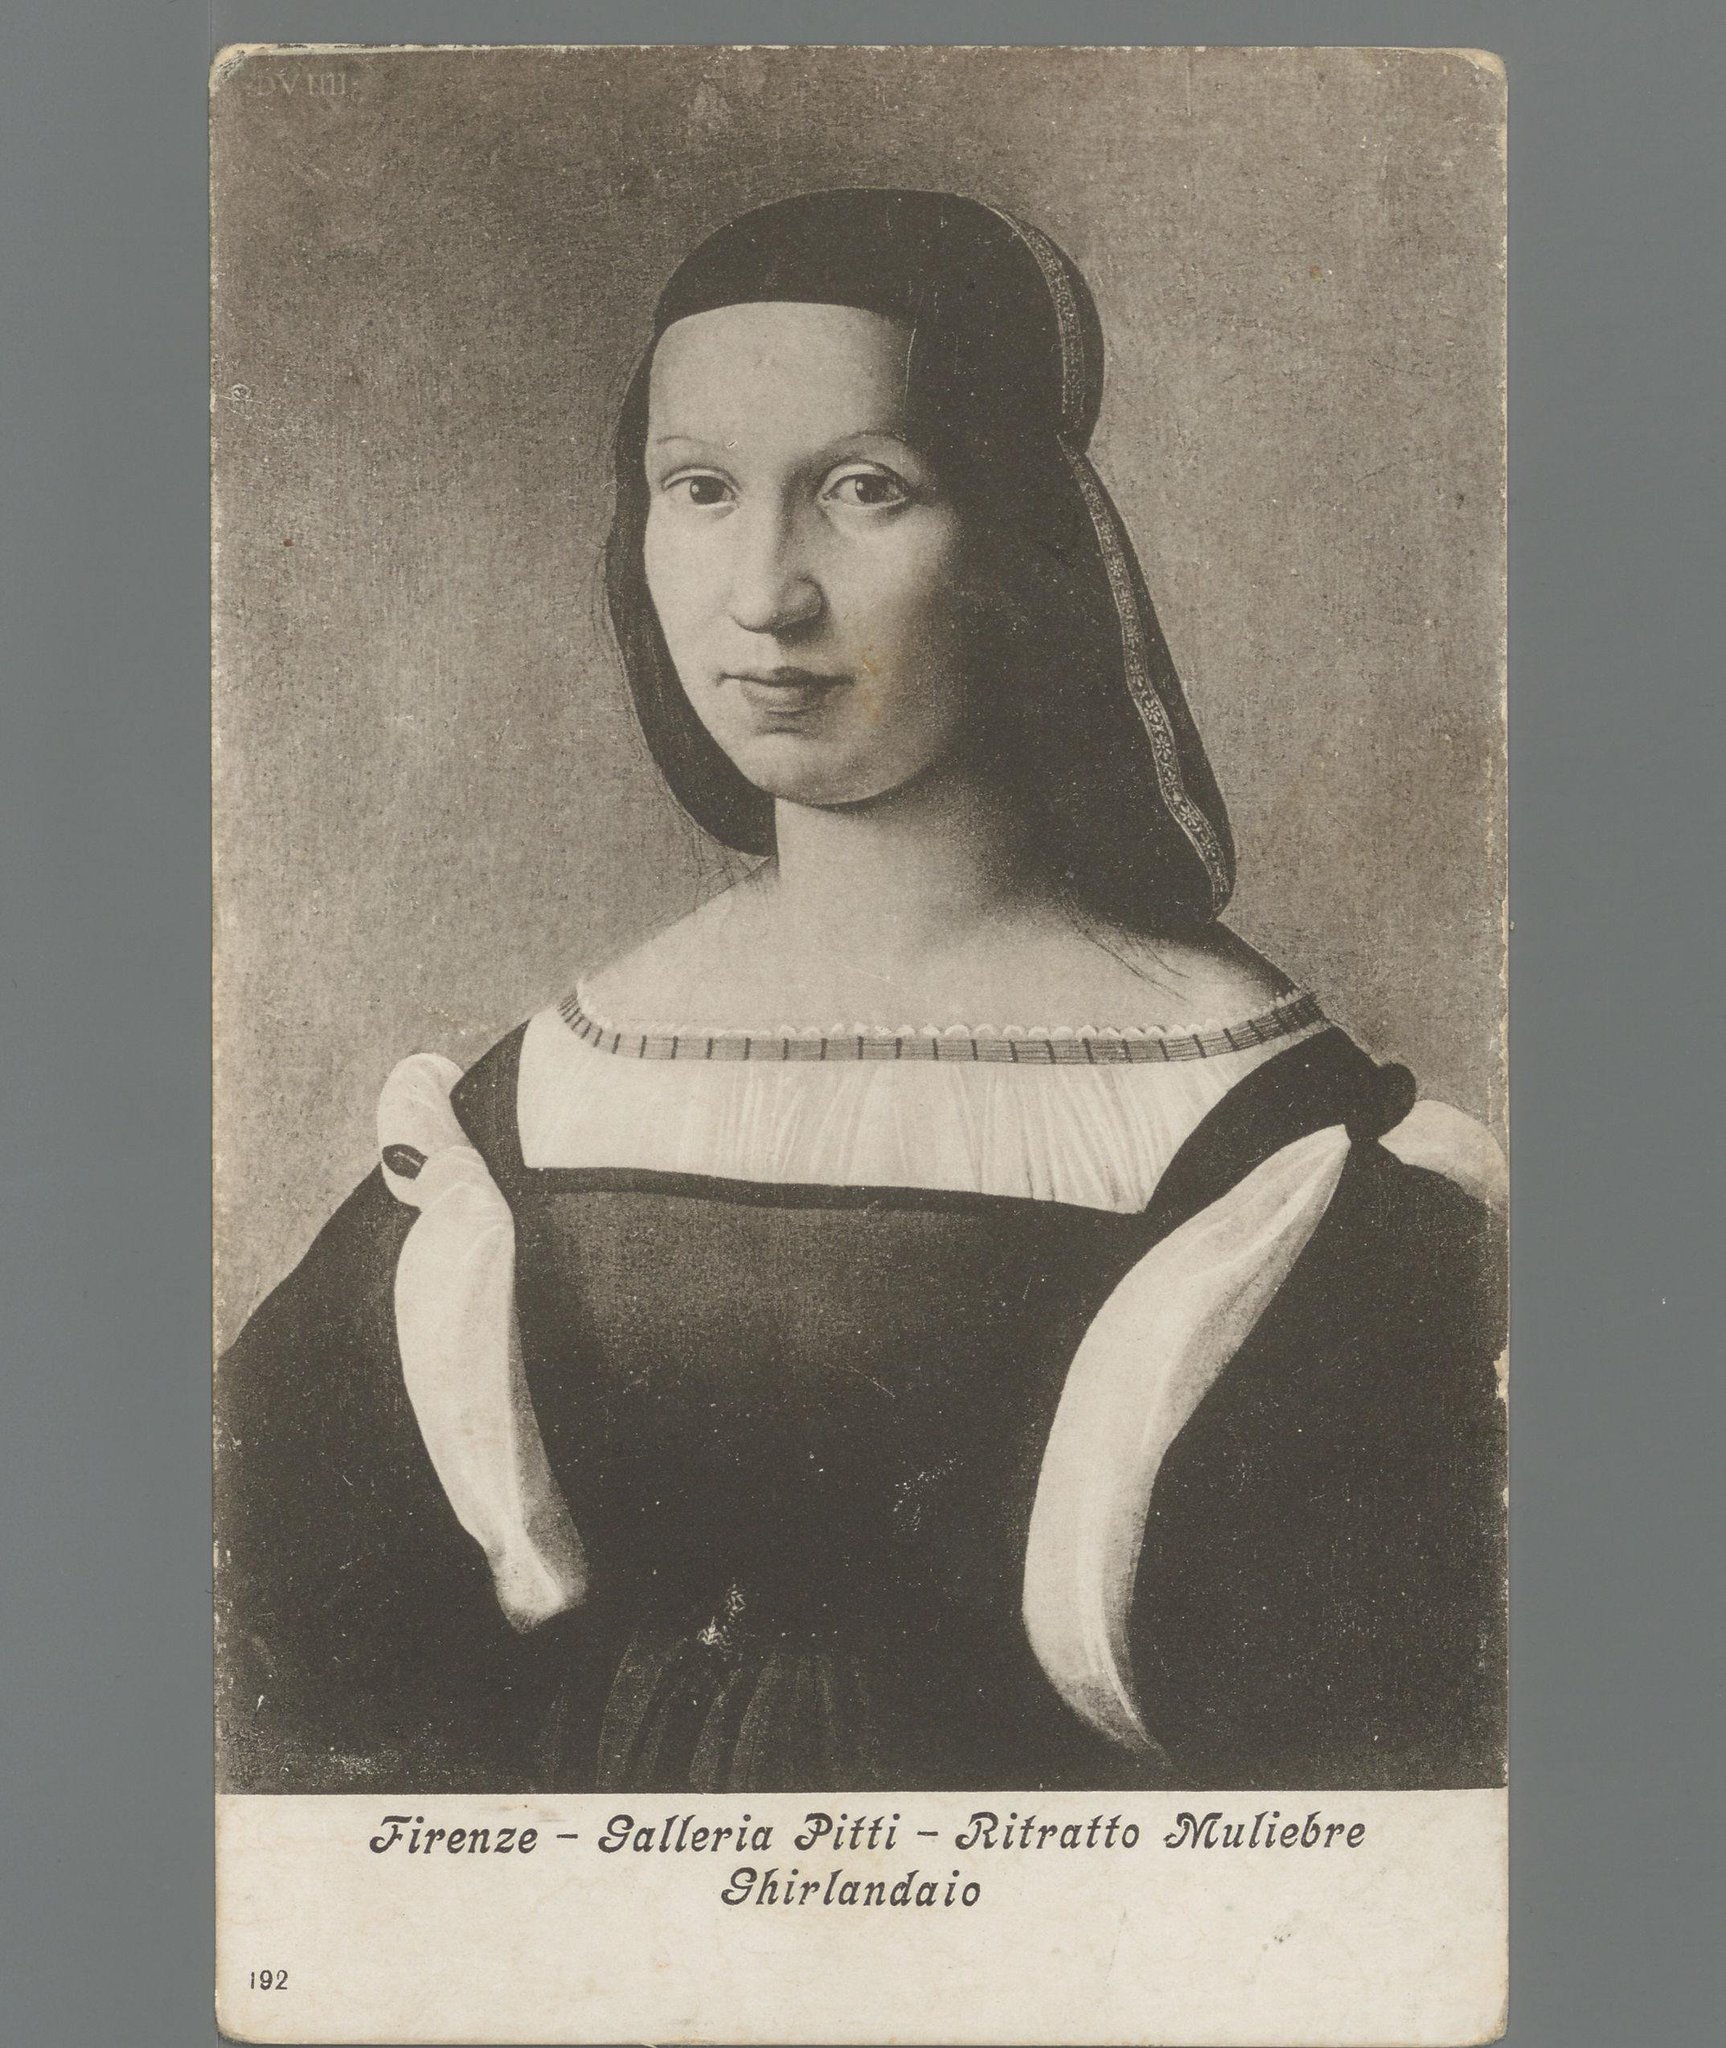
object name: ansichtkaart, prentbriefkaart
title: Firenze - Galleria Pitti. Ritratto Muliebre. Ghirlandaio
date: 1906-1930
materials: cardboard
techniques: photograph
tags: permanent exhibition, museum, picture, painting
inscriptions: collector's mark: ‘AFE v S’, monogram